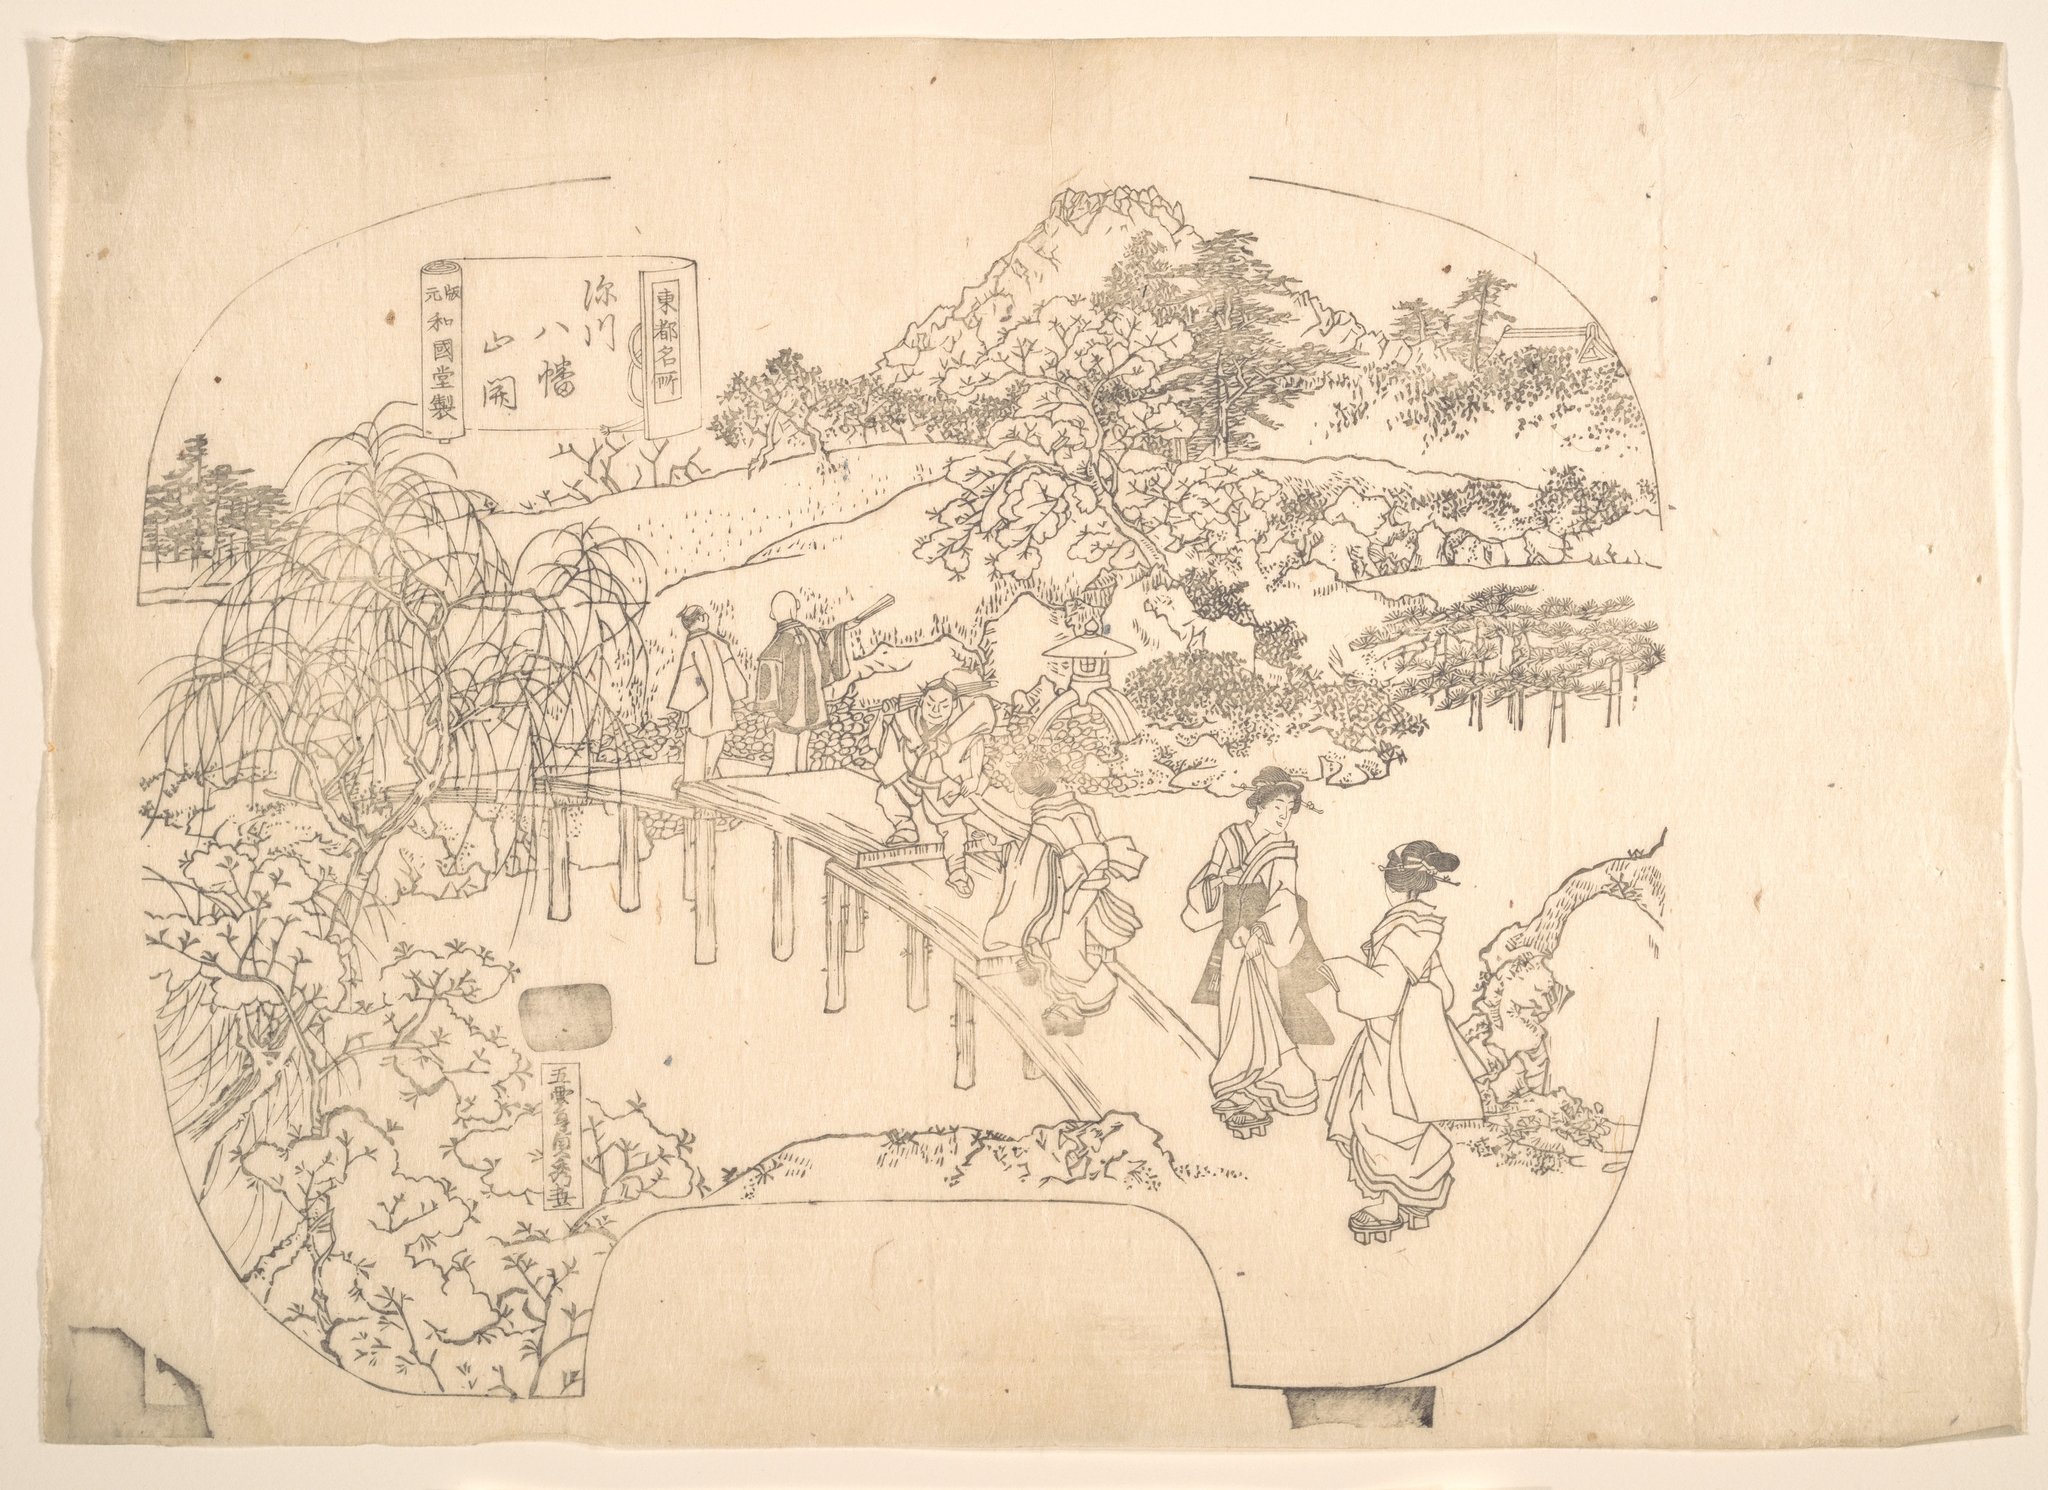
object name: print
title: Proof Line-Block Print for Fan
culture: japanese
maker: utagawa (gountei) sadahide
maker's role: artist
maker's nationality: japanese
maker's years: 1807-1873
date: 1801-1900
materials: ink, paper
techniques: line block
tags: bridges,men,women,trees